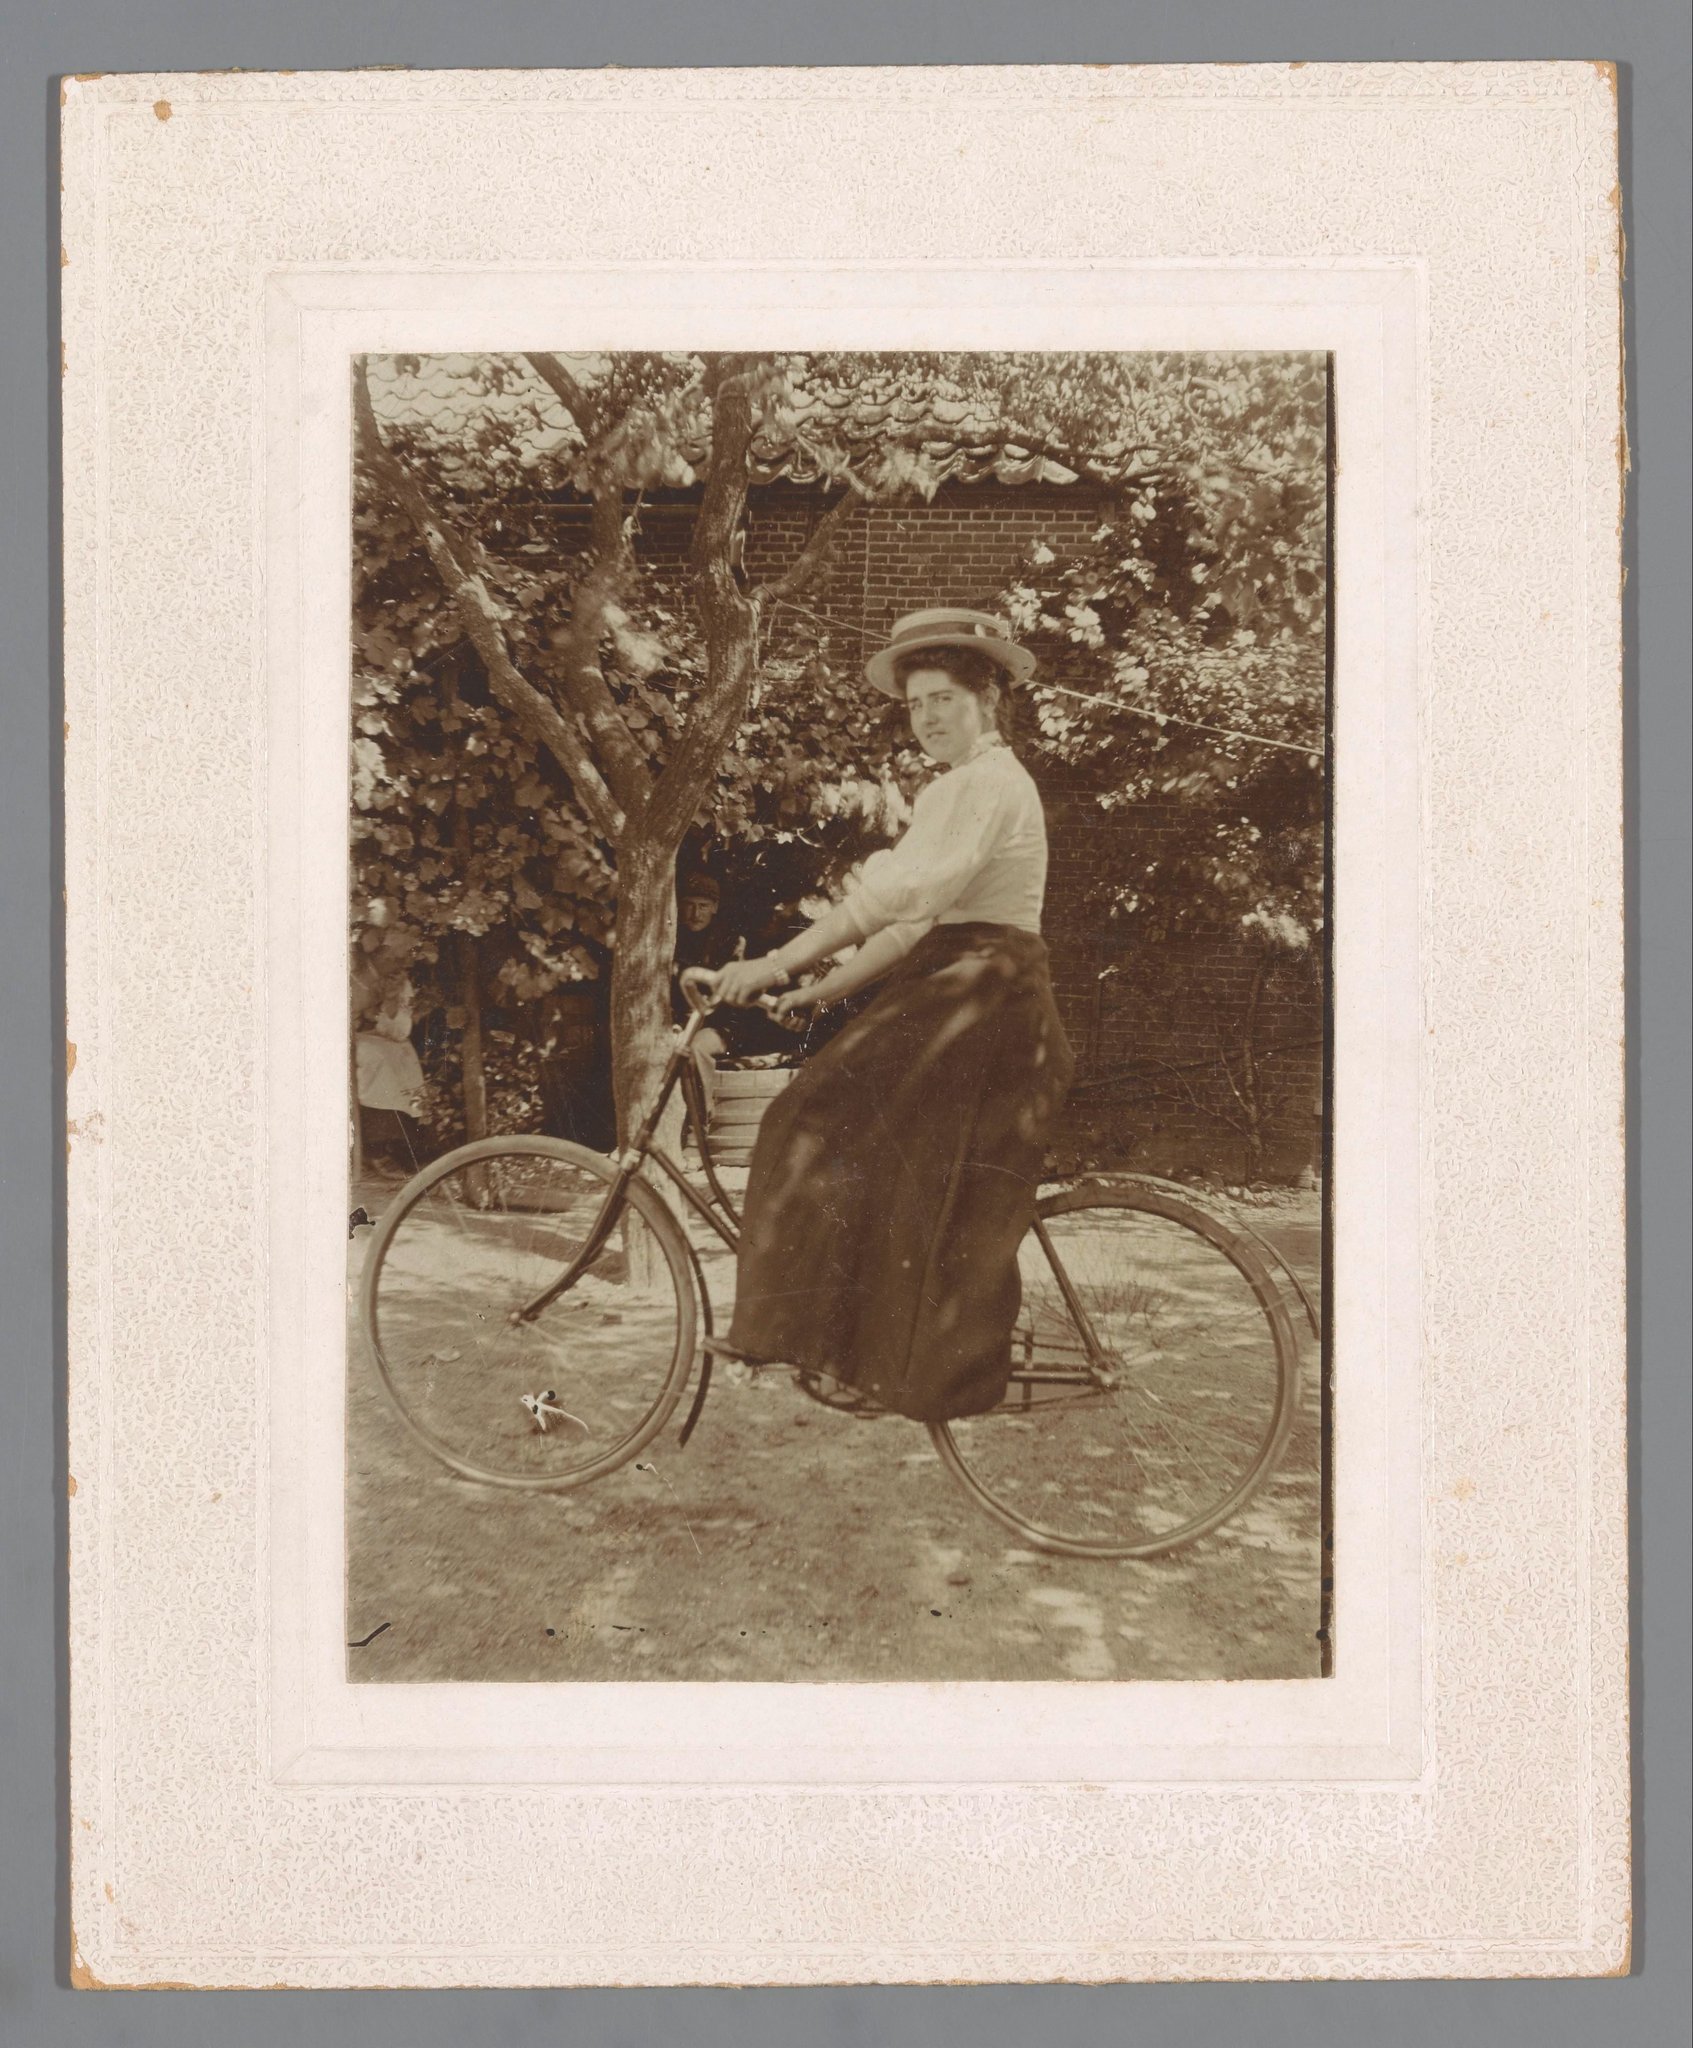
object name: photograph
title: Portret van een onbekende vrouw op een fiets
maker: Anonymous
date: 1895-1915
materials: cardboard, photographic support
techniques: gelatin silver print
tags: adult woman, bicycle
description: RP-F-F21385 is op dezelfde plek gemaakt.